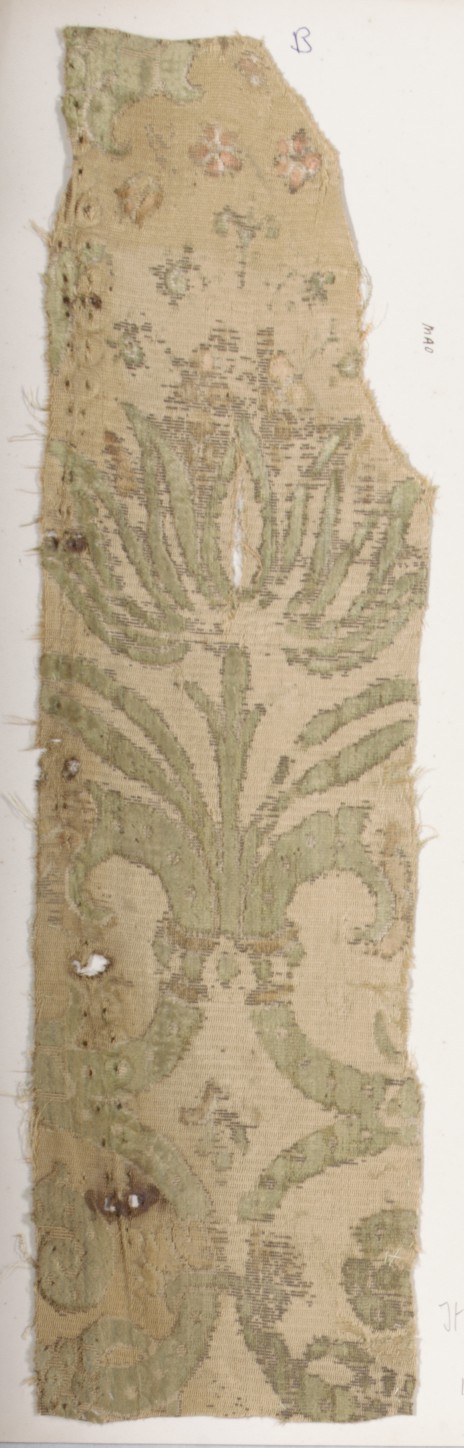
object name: fragment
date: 1601-1700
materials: metal thread, silk